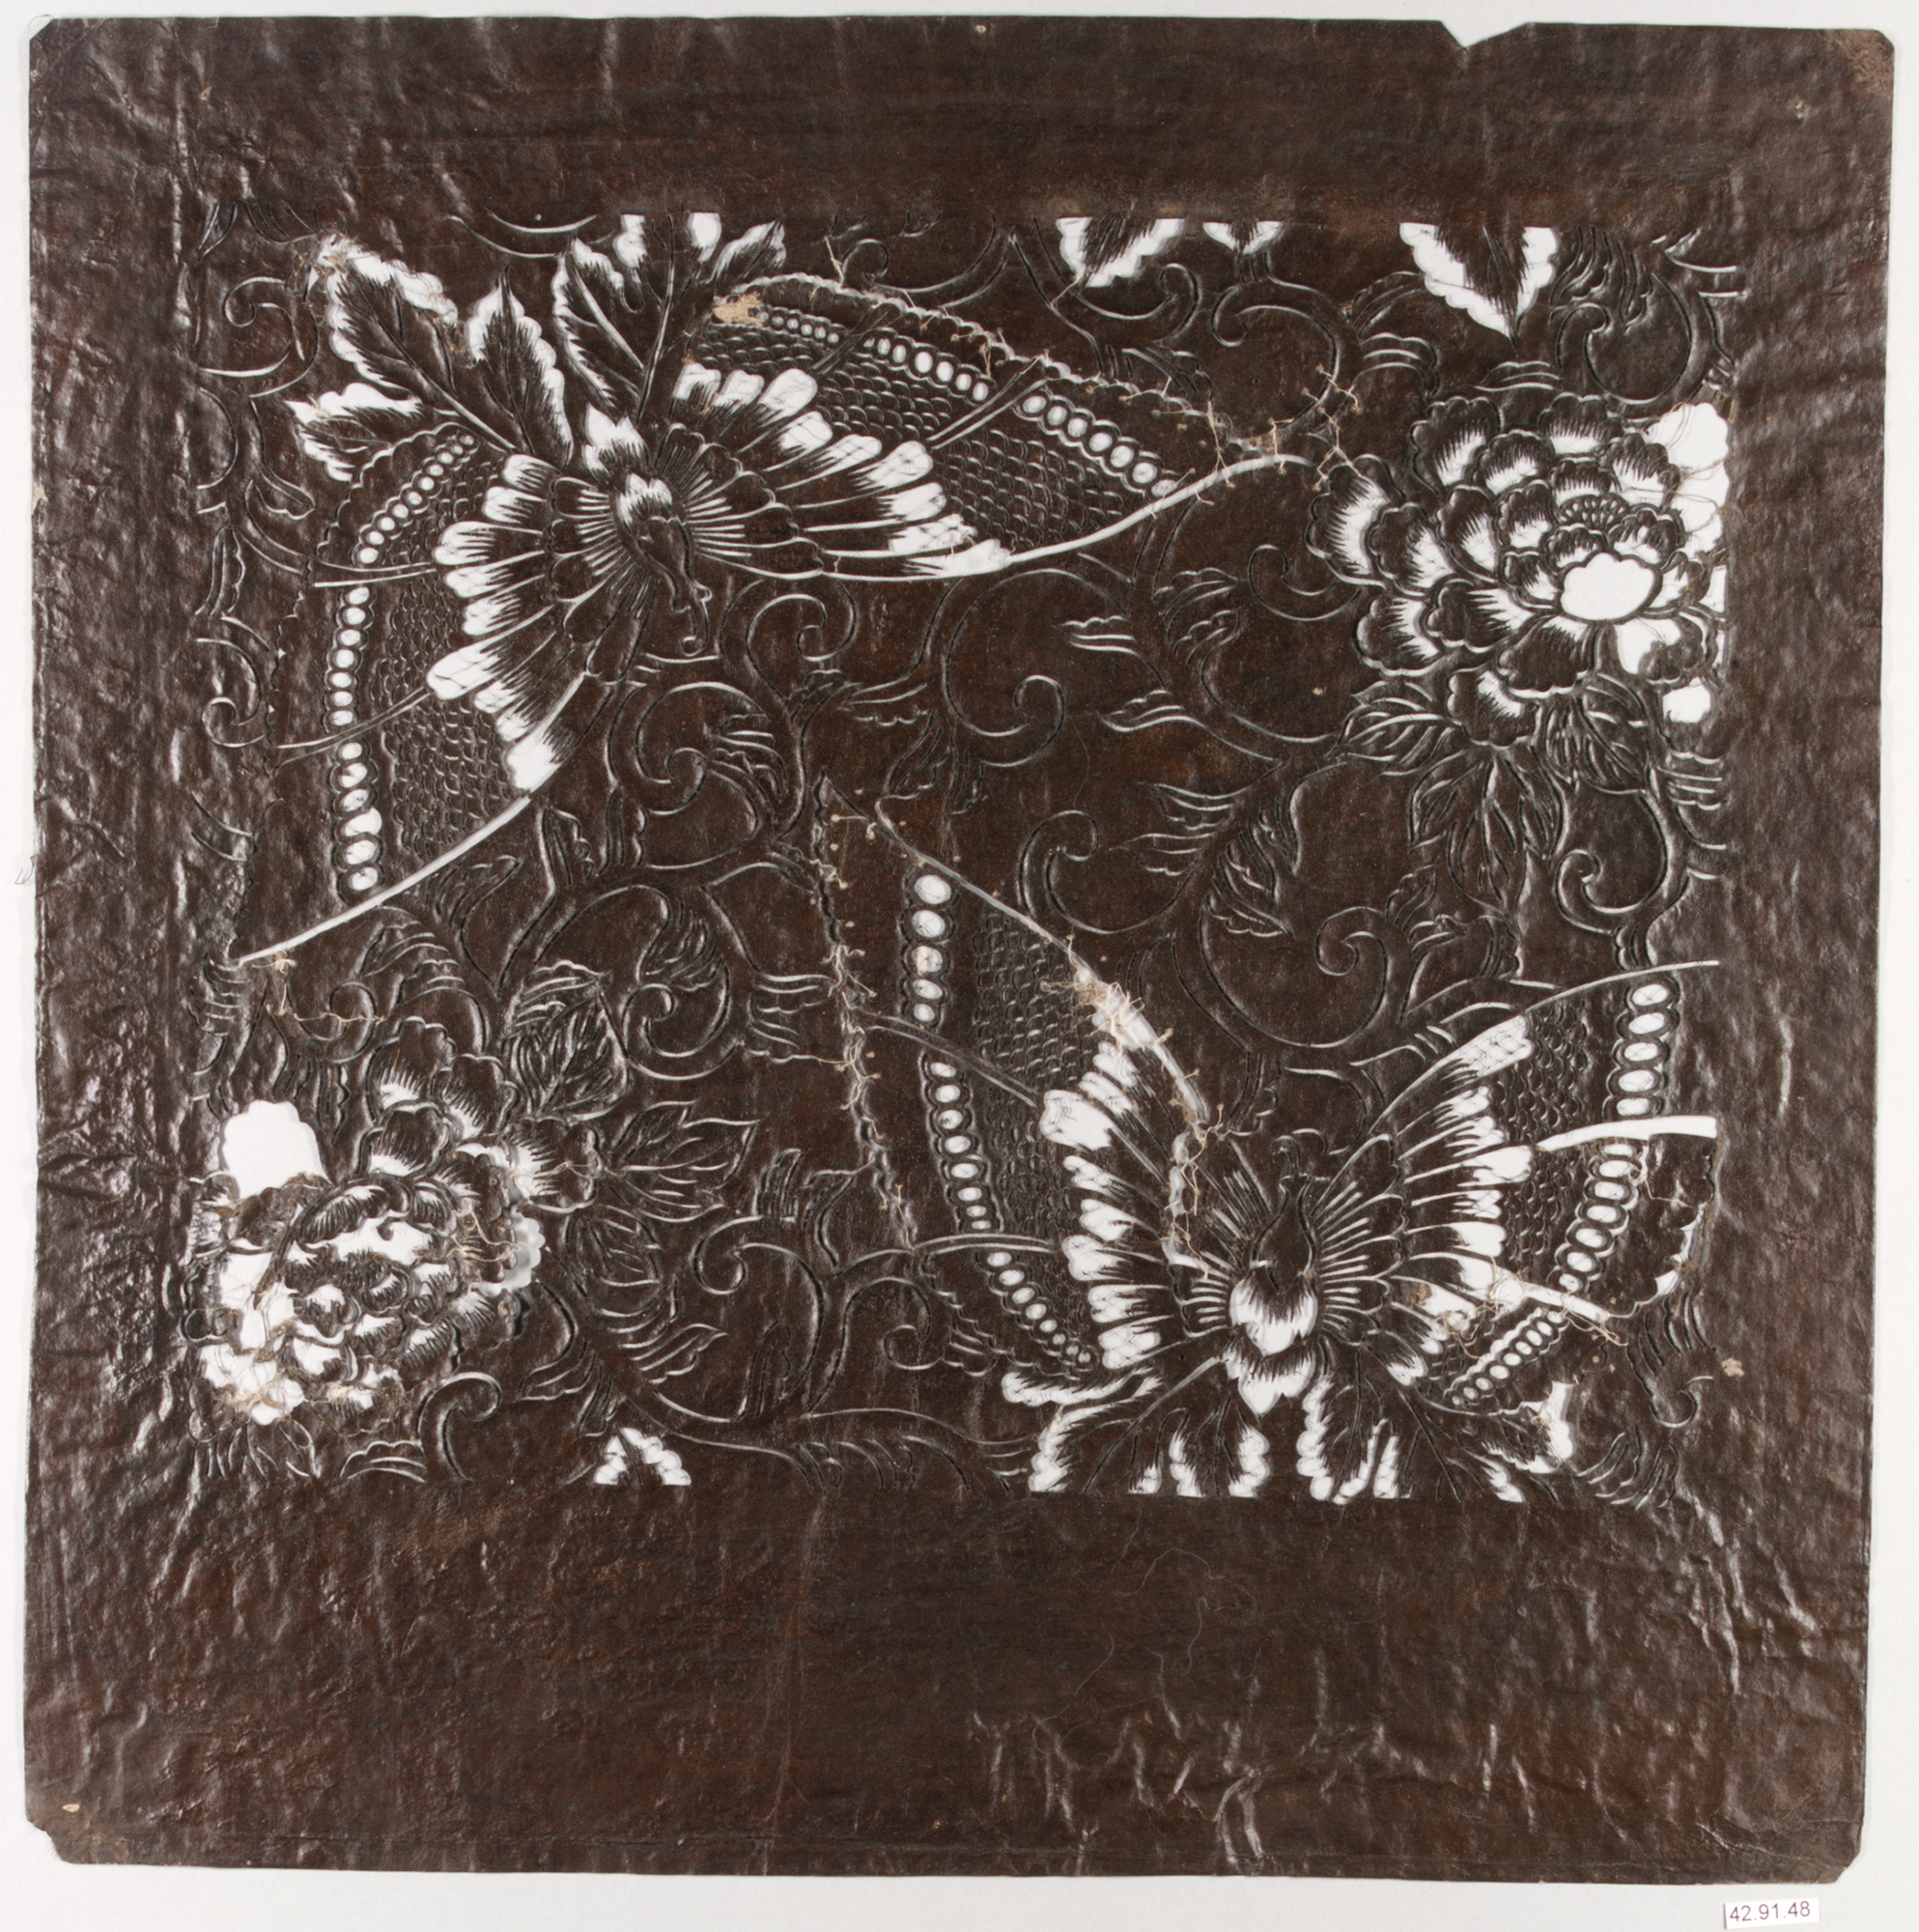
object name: stencil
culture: japanese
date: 1801-1900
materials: paper, silk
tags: butterflies,peonies